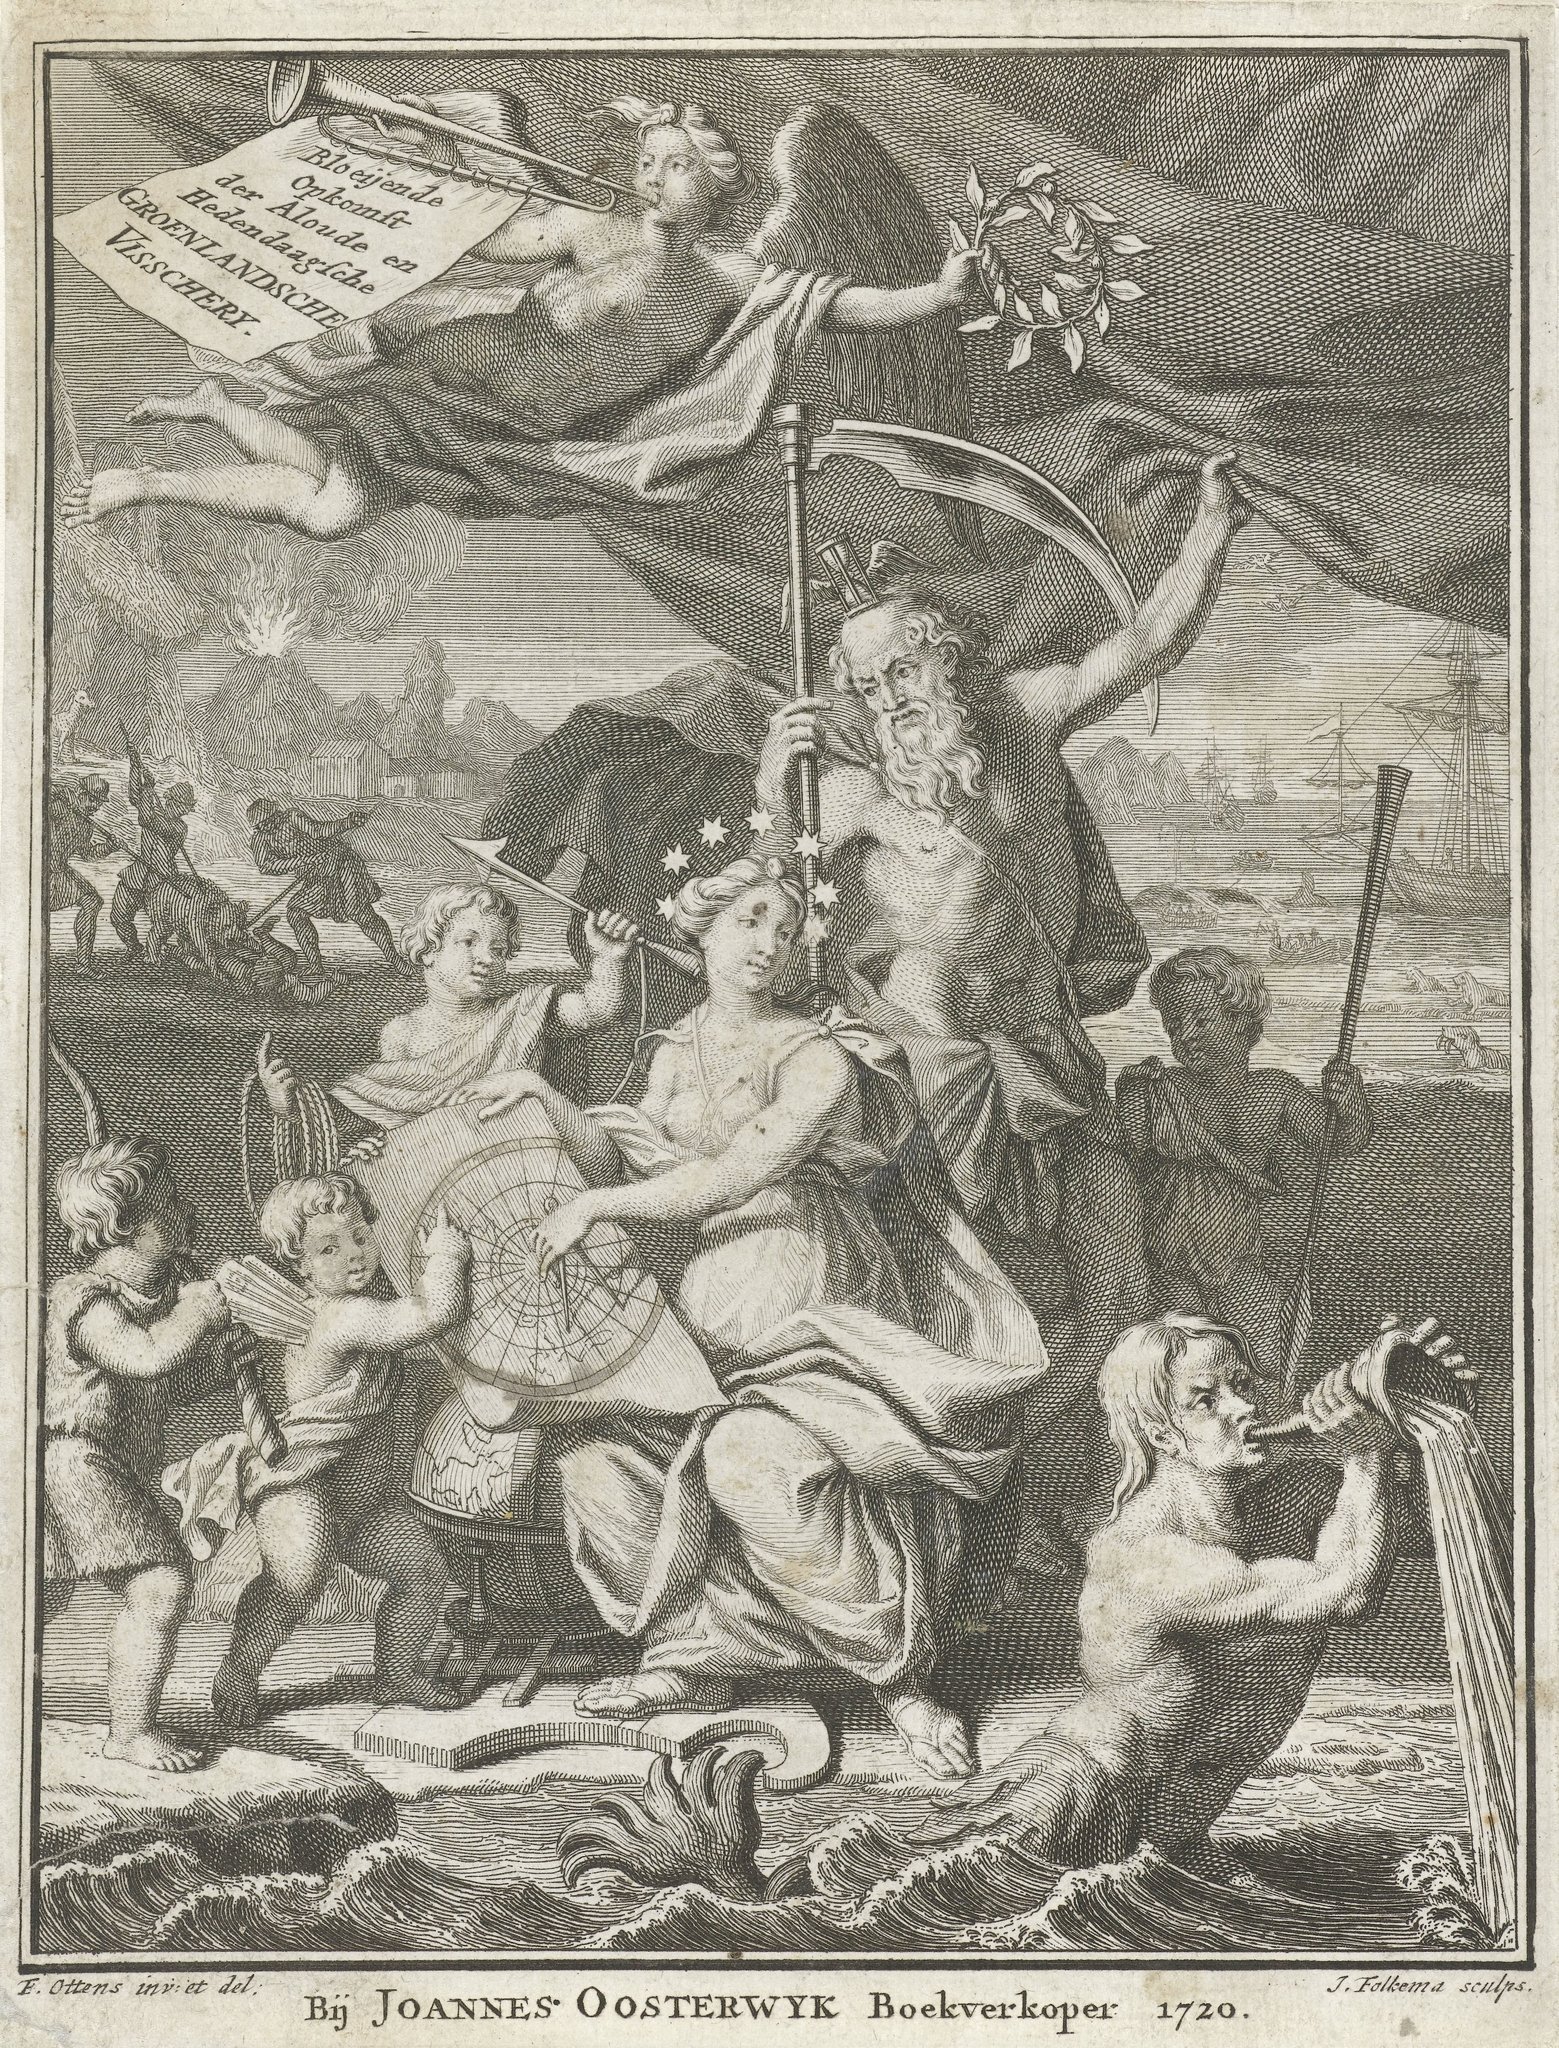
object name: print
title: Allegorische voorstelling met Urania en Vader Tijd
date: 1720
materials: paper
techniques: engraving, etching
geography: amsterdam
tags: urania (one of the muses); 'urania' (ripa), fame; 'fama', 'fama buona', 'fama chiara' (ripa), cupids: 'amores', 'amoretti', 'putti', father time, man with wings and scythe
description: Urania,de muze van de Astronomie, zit met sterren gekroond, naast een globe en meet met een passer cirkels op een vel papier. Achter haar staat Vader Tijd met een zeis in zijn handen en een gevleugelde zandloper op zijn hoofd. Dit tweetal wordt omringd door putti. In de lucht vliegt een bazuin blazende engel met een lauwerkrans in haar handen. Geheel op de voorgrond blaast een riviergod op een schelp waar water uit loopt. De achtergrond toont links een kust met zeilschepen, rechts doden drie figuren een beer.